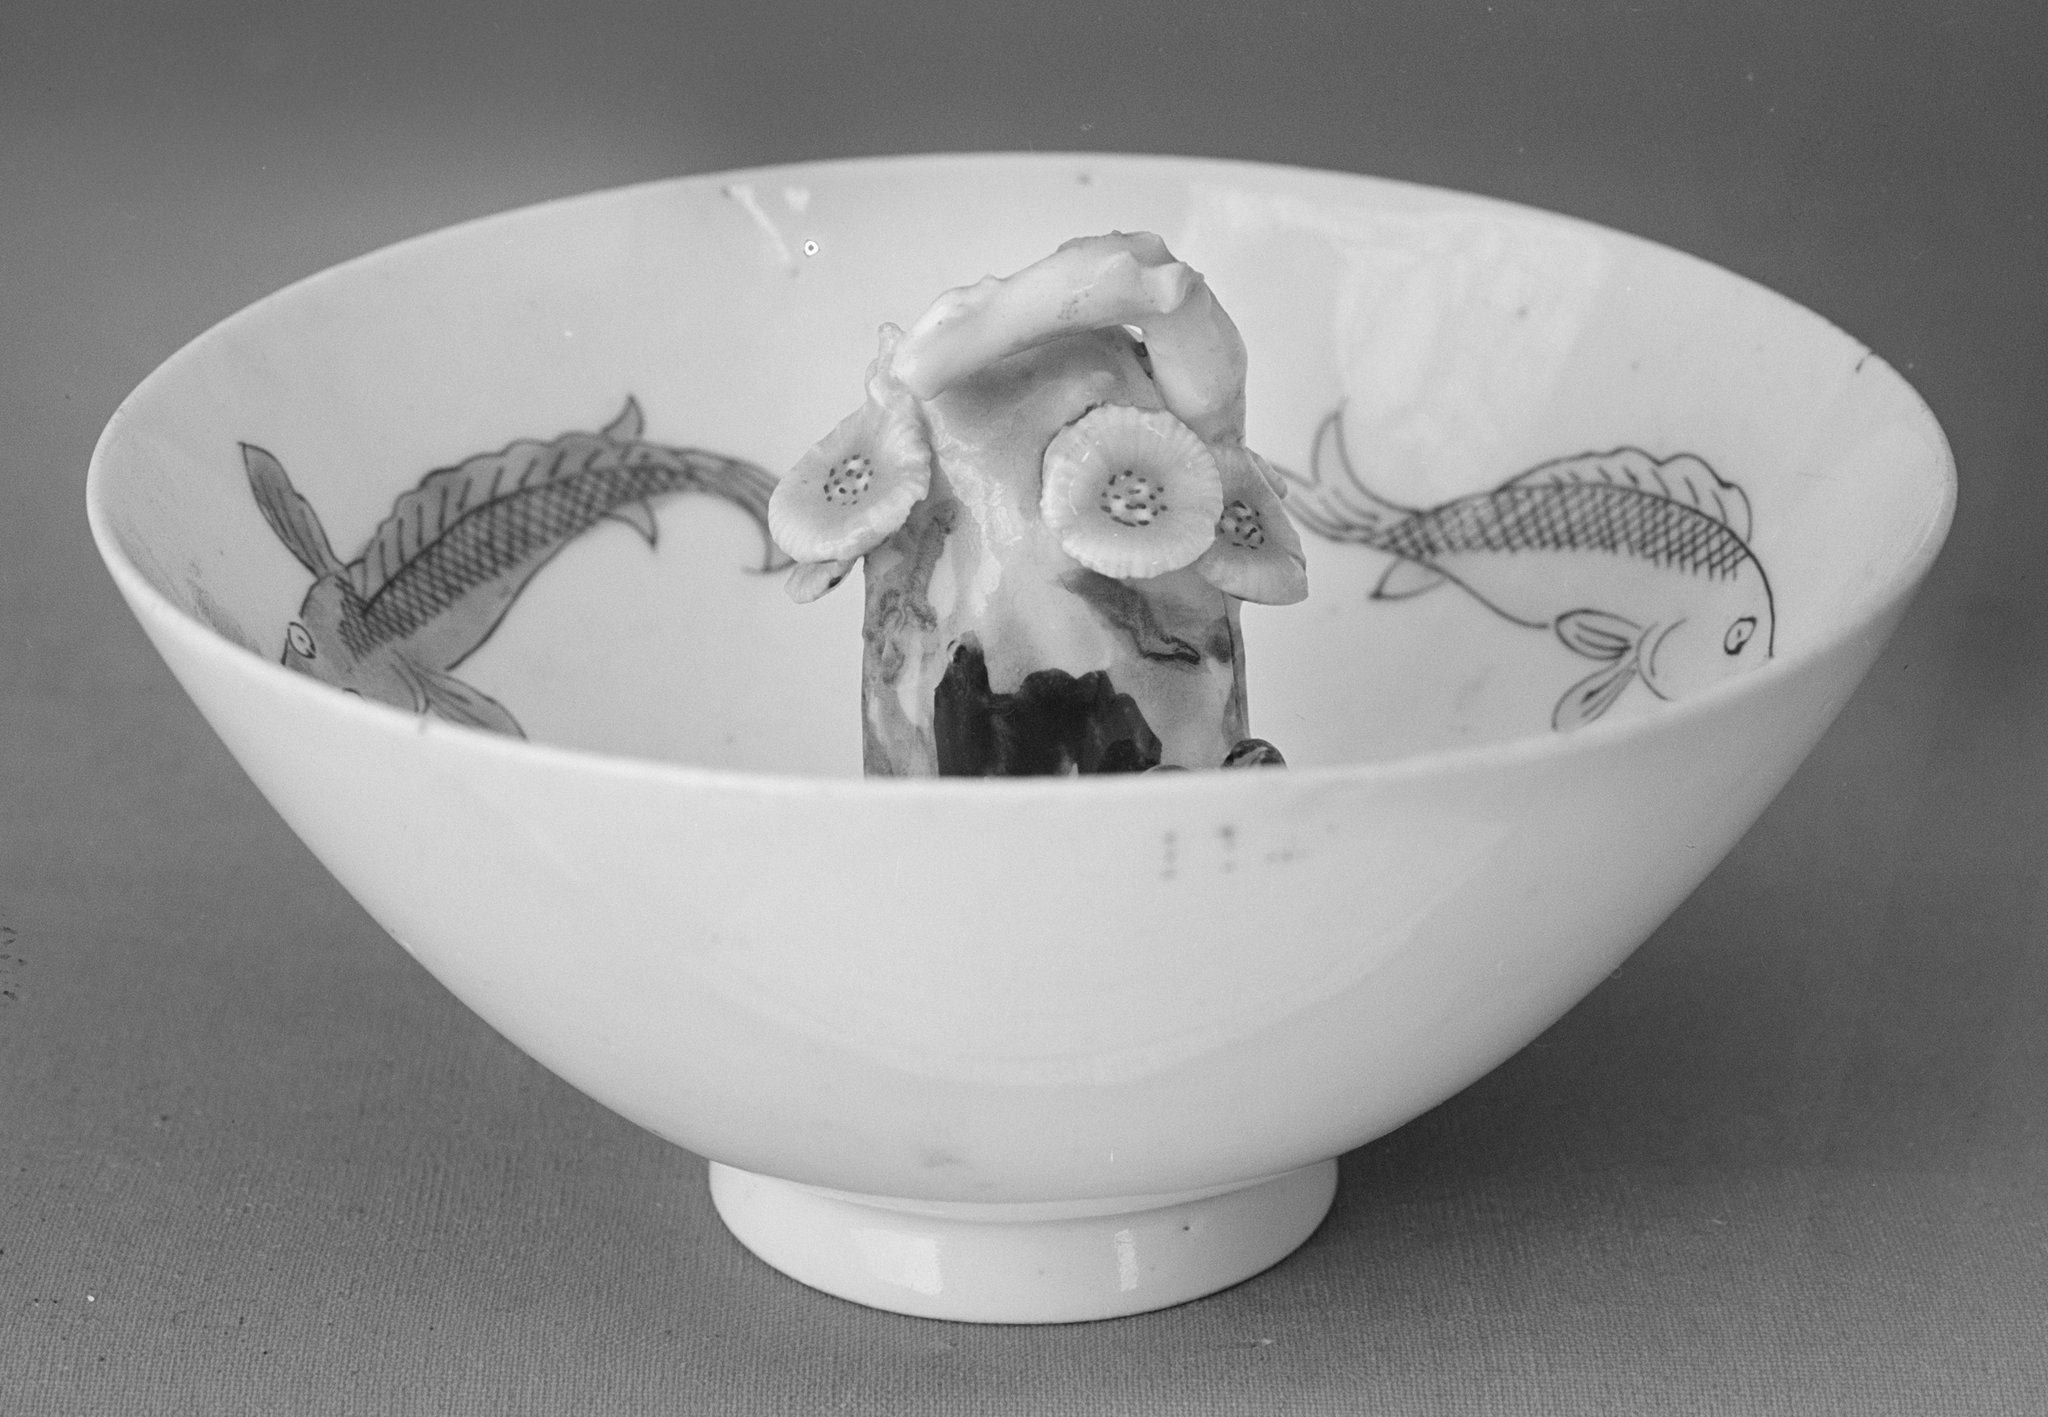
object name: bowl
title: "Trick" Bowl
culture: chinese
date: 1801-1850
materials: enamel, porcelain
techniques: overglaze, painting, polychrome, relief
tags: fish